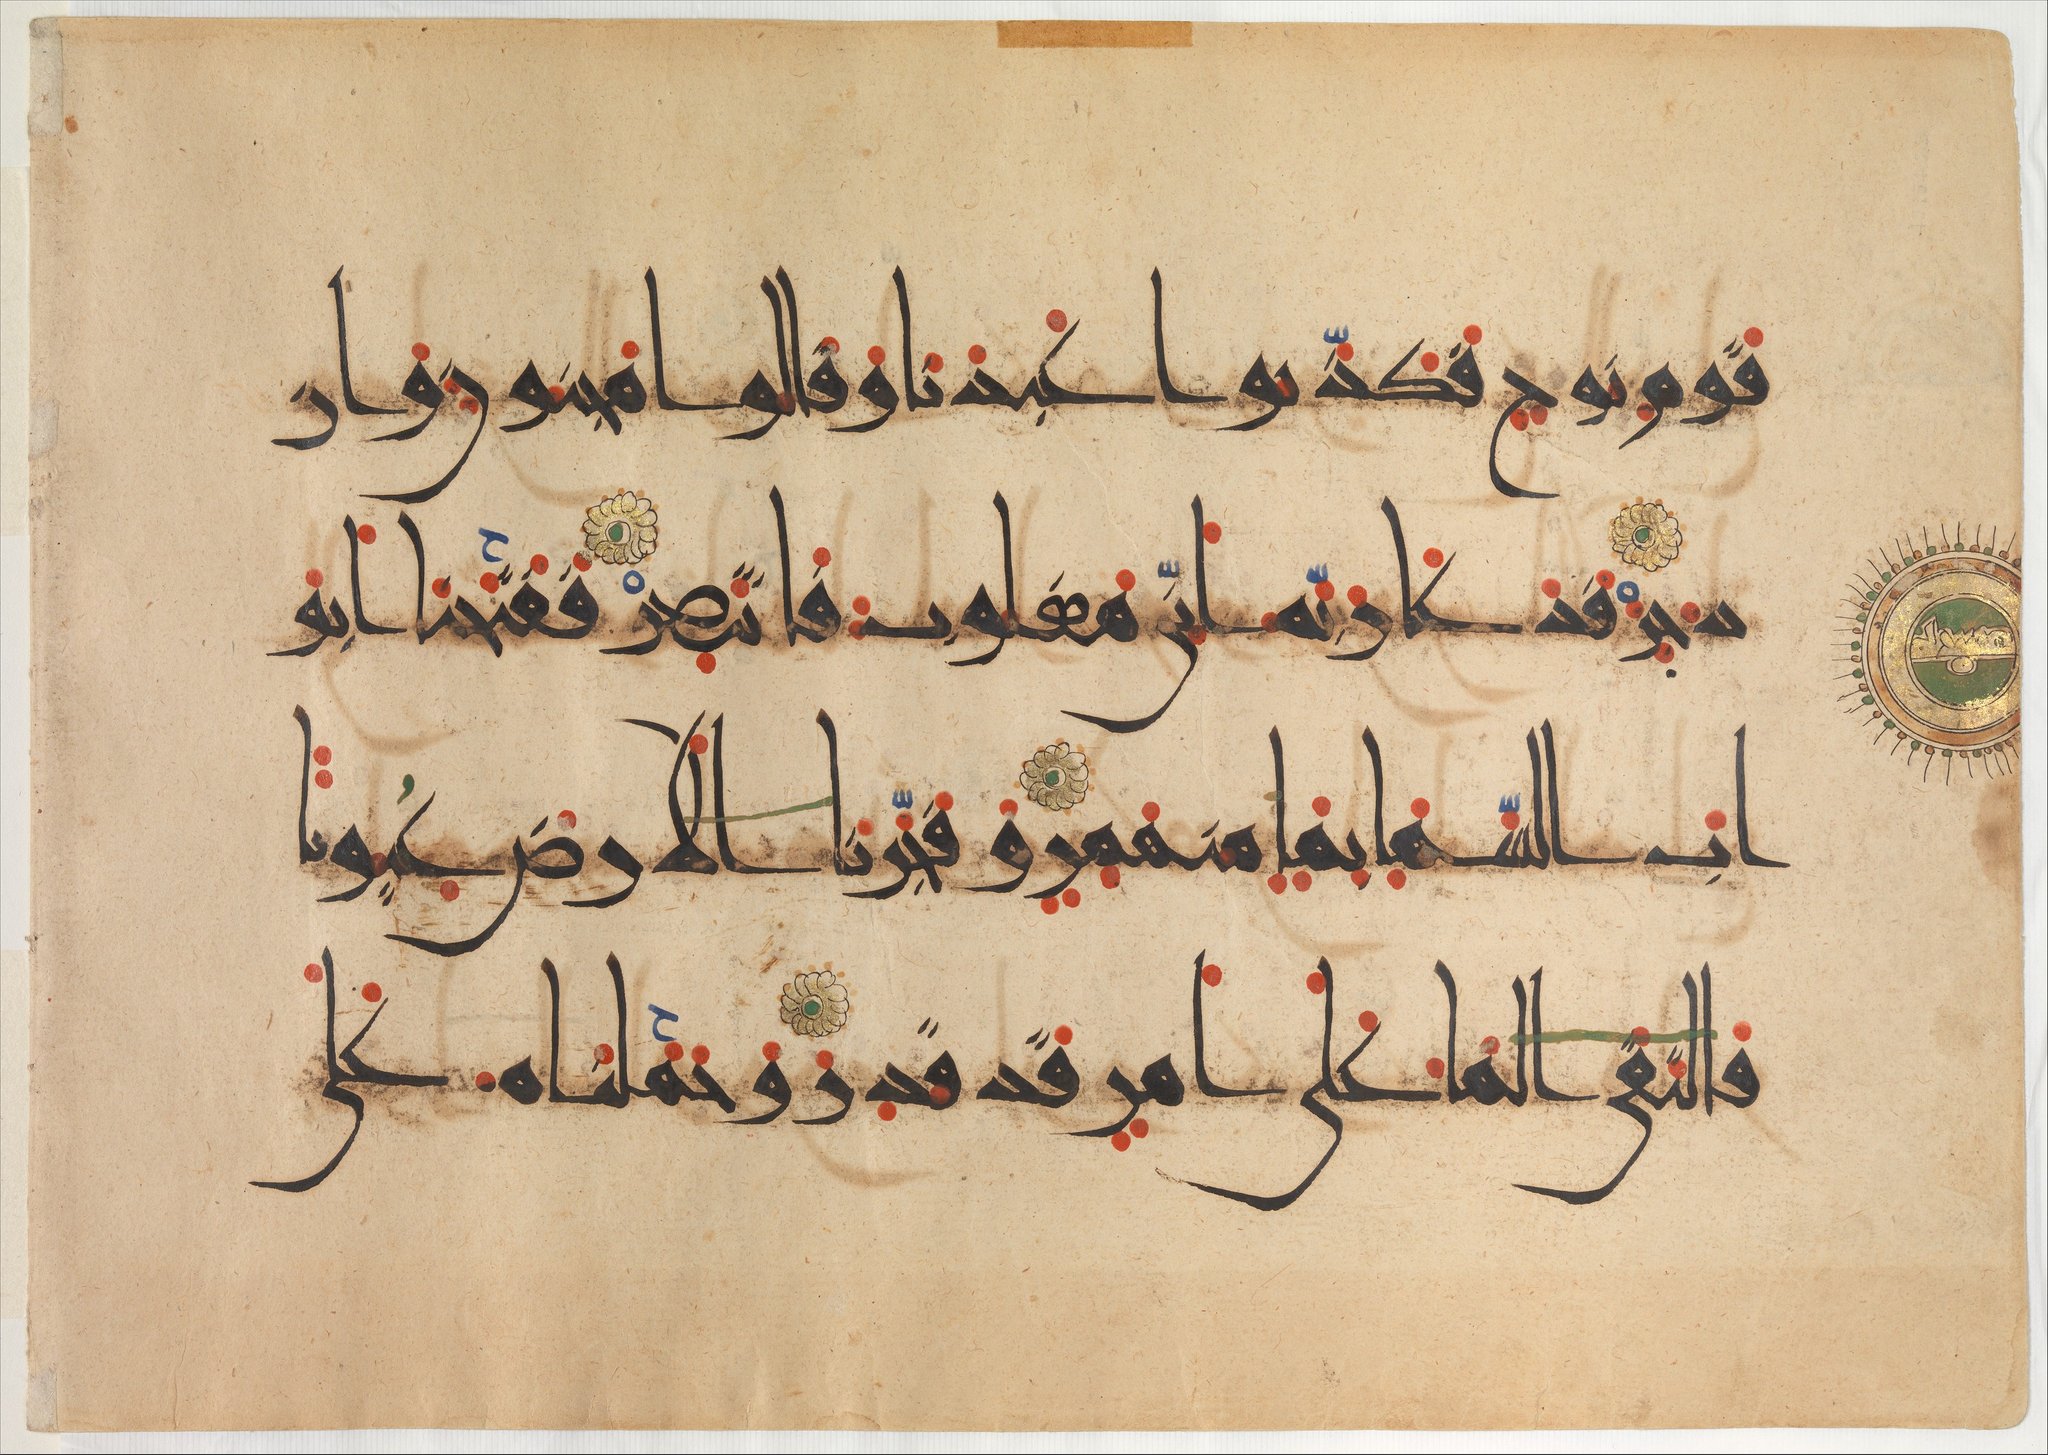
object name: folio from a non illustrated manuscript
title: Folios from a Qur'an Manuscript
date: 383-993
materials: gold, ink, paper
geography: iran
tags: qur'an,calligraphy